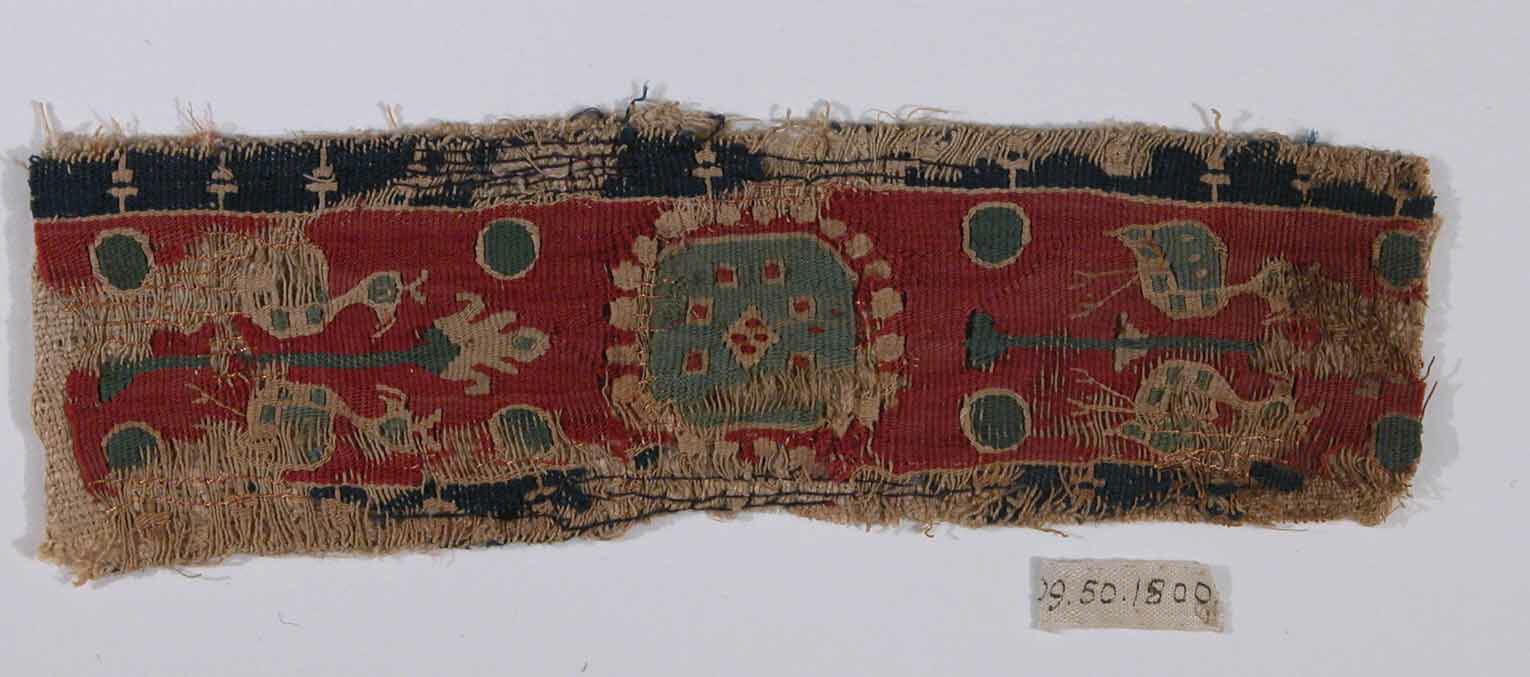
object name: band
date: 501-700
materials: linen, wool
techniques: weave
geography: egypt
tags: birds